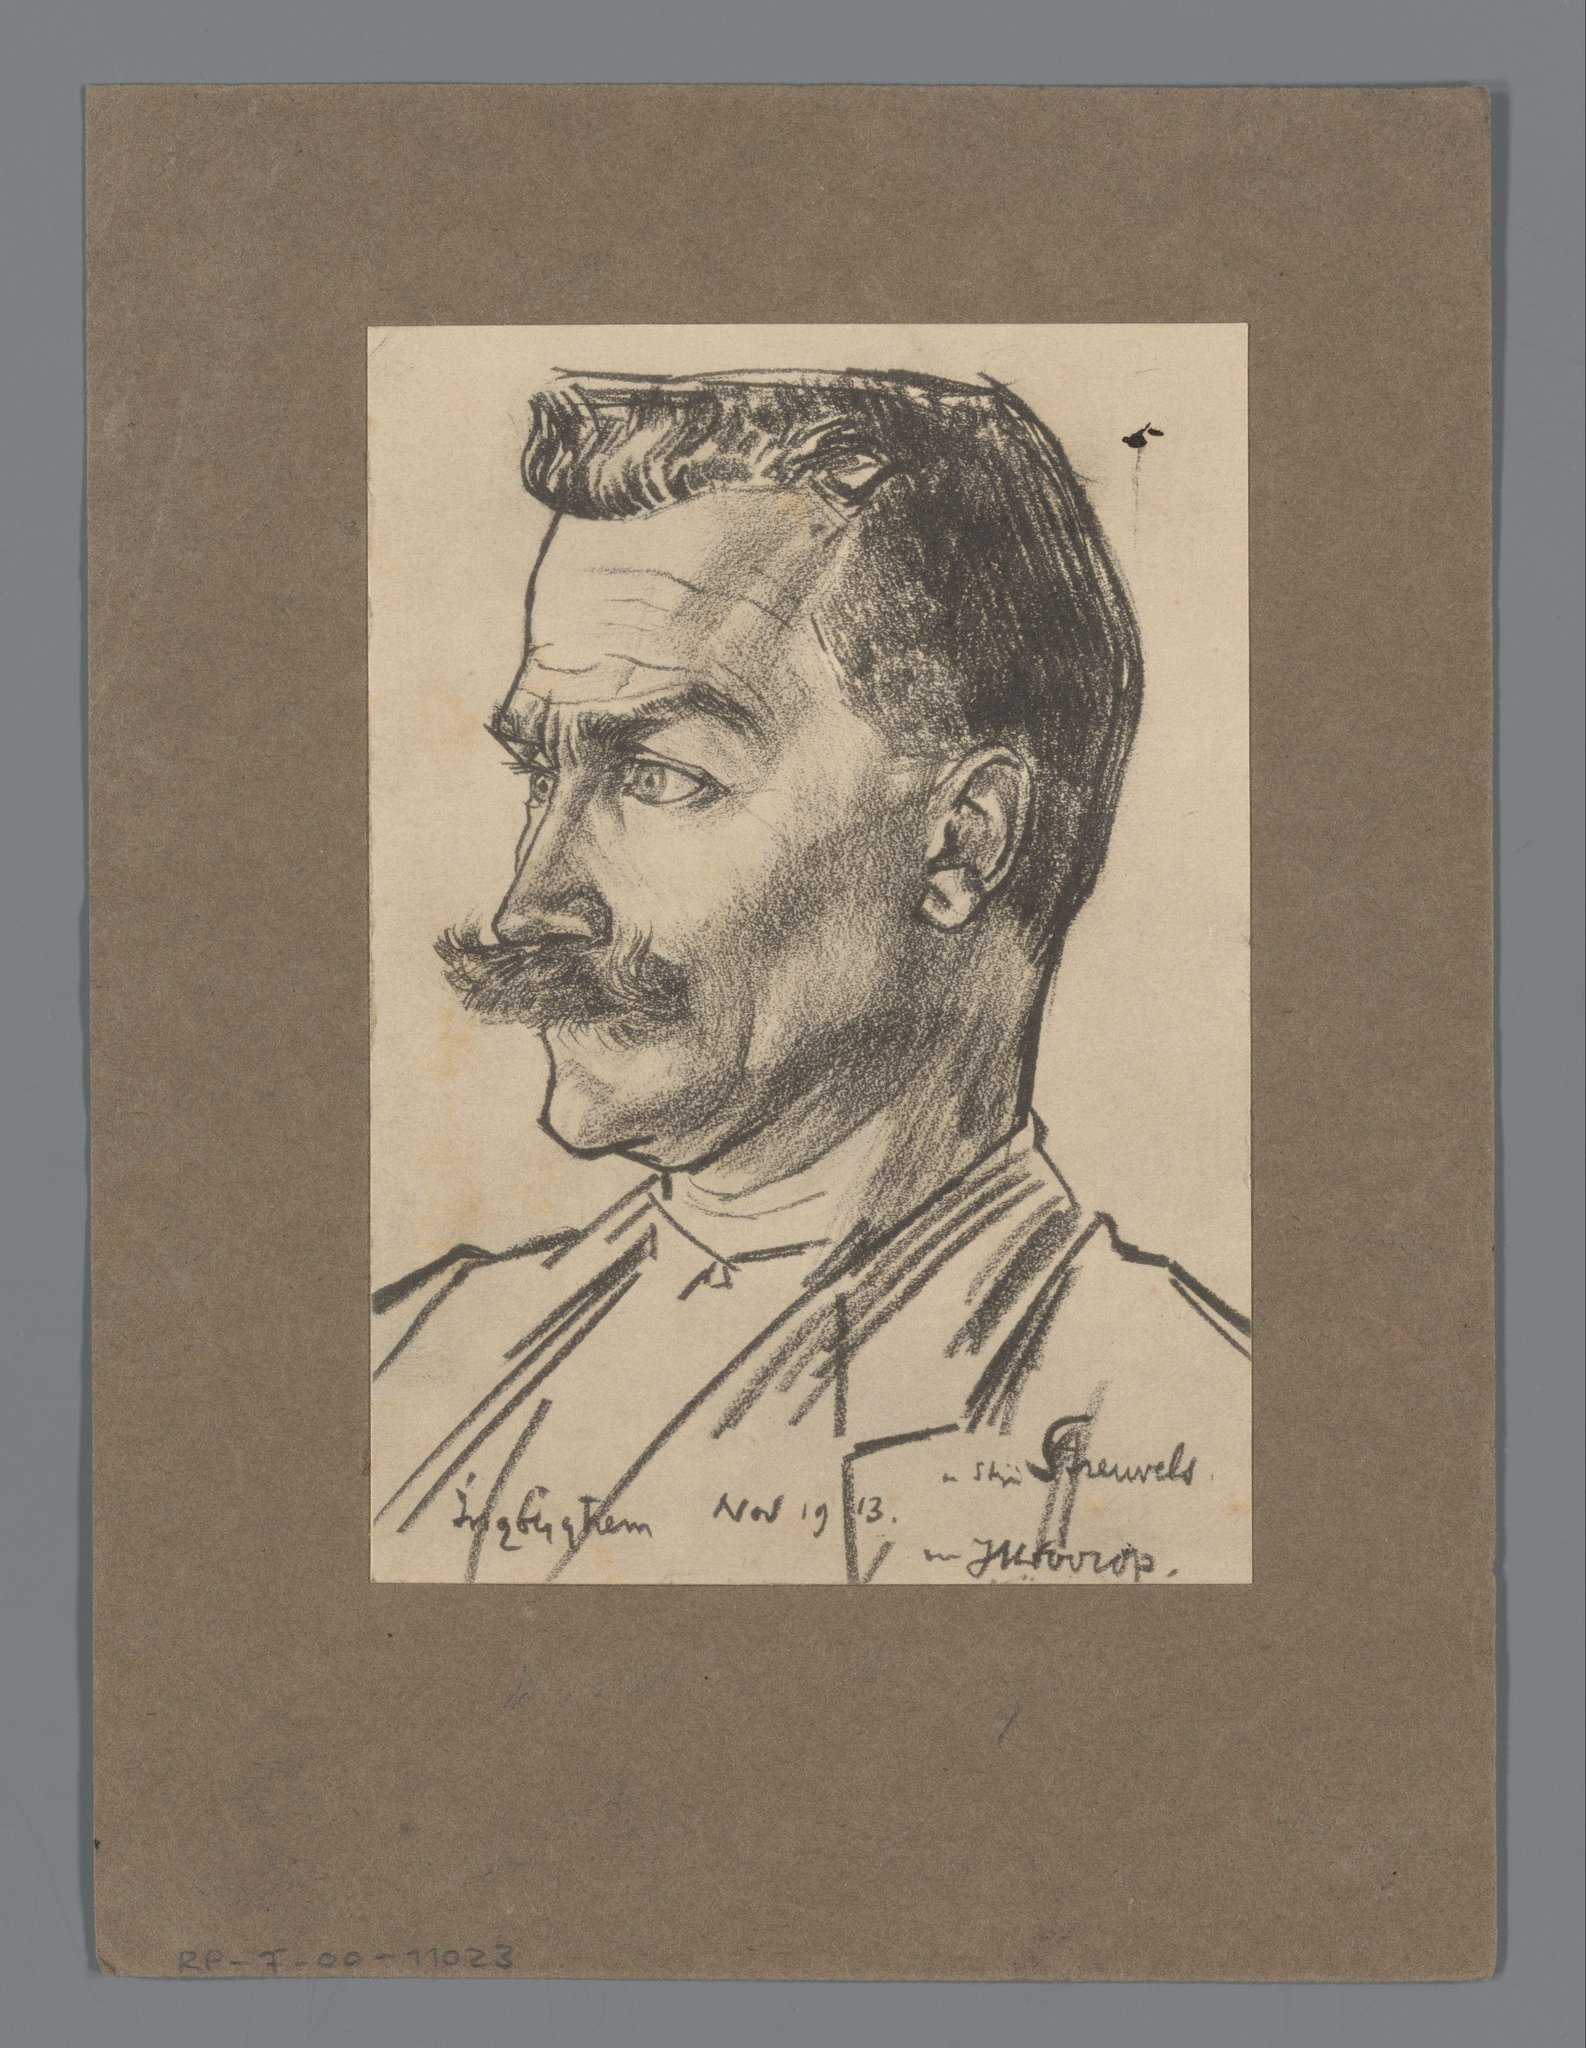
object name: reproduction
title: Reproductie van een getekend portret van Stijn Streuvels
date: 1911-1913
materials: paper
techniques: photograph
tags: stijn streuvels, portrait of a writer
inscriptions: clichéaanwijzing, verso, handgeschreven